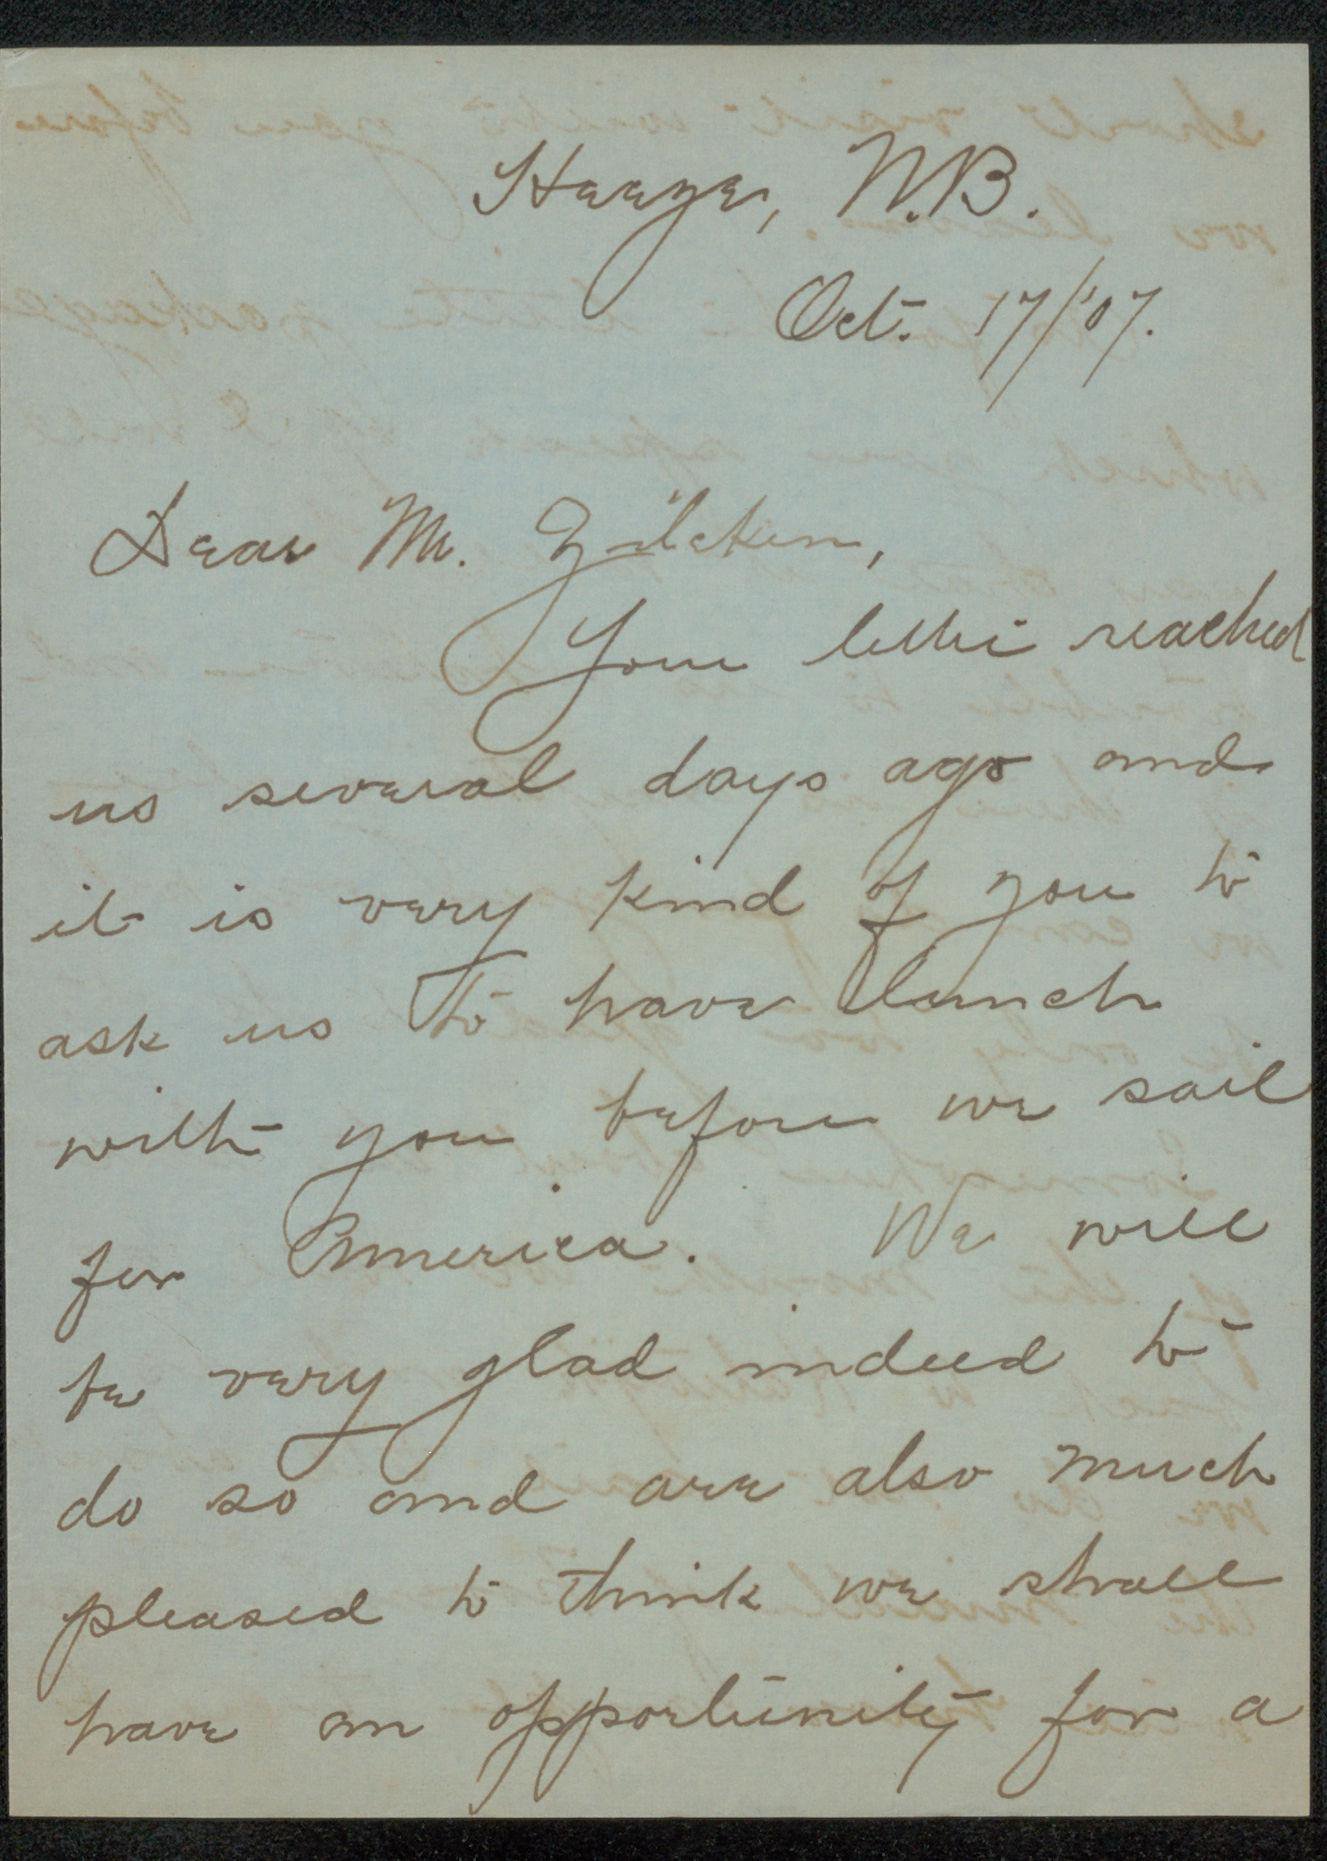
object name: letter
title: Brief aan Philip Zilcken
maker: walter castle keith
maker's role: painter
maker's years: 1863-1927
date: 1907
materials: ink, paper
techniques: pen, writing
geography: heeze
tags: draughtsman, philip zilcken, the hague, paris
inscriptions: collector's mark: ‘RPK’